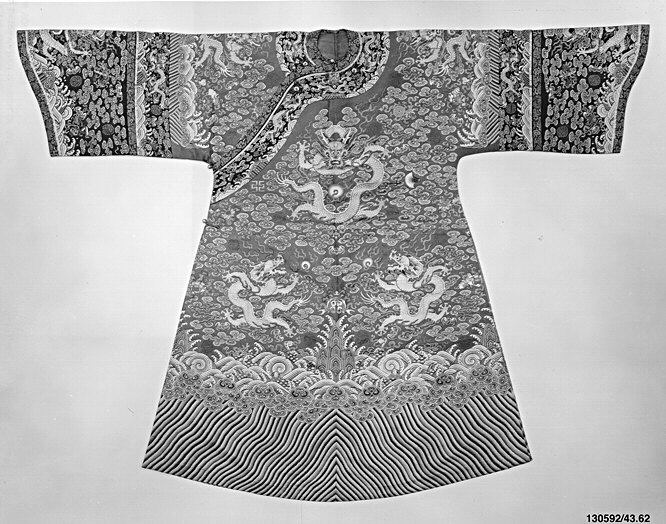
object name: robe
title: Festival Robe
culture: chinese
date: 1767-1833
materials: textile, metal thread, silk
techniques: embroidery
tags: dragons